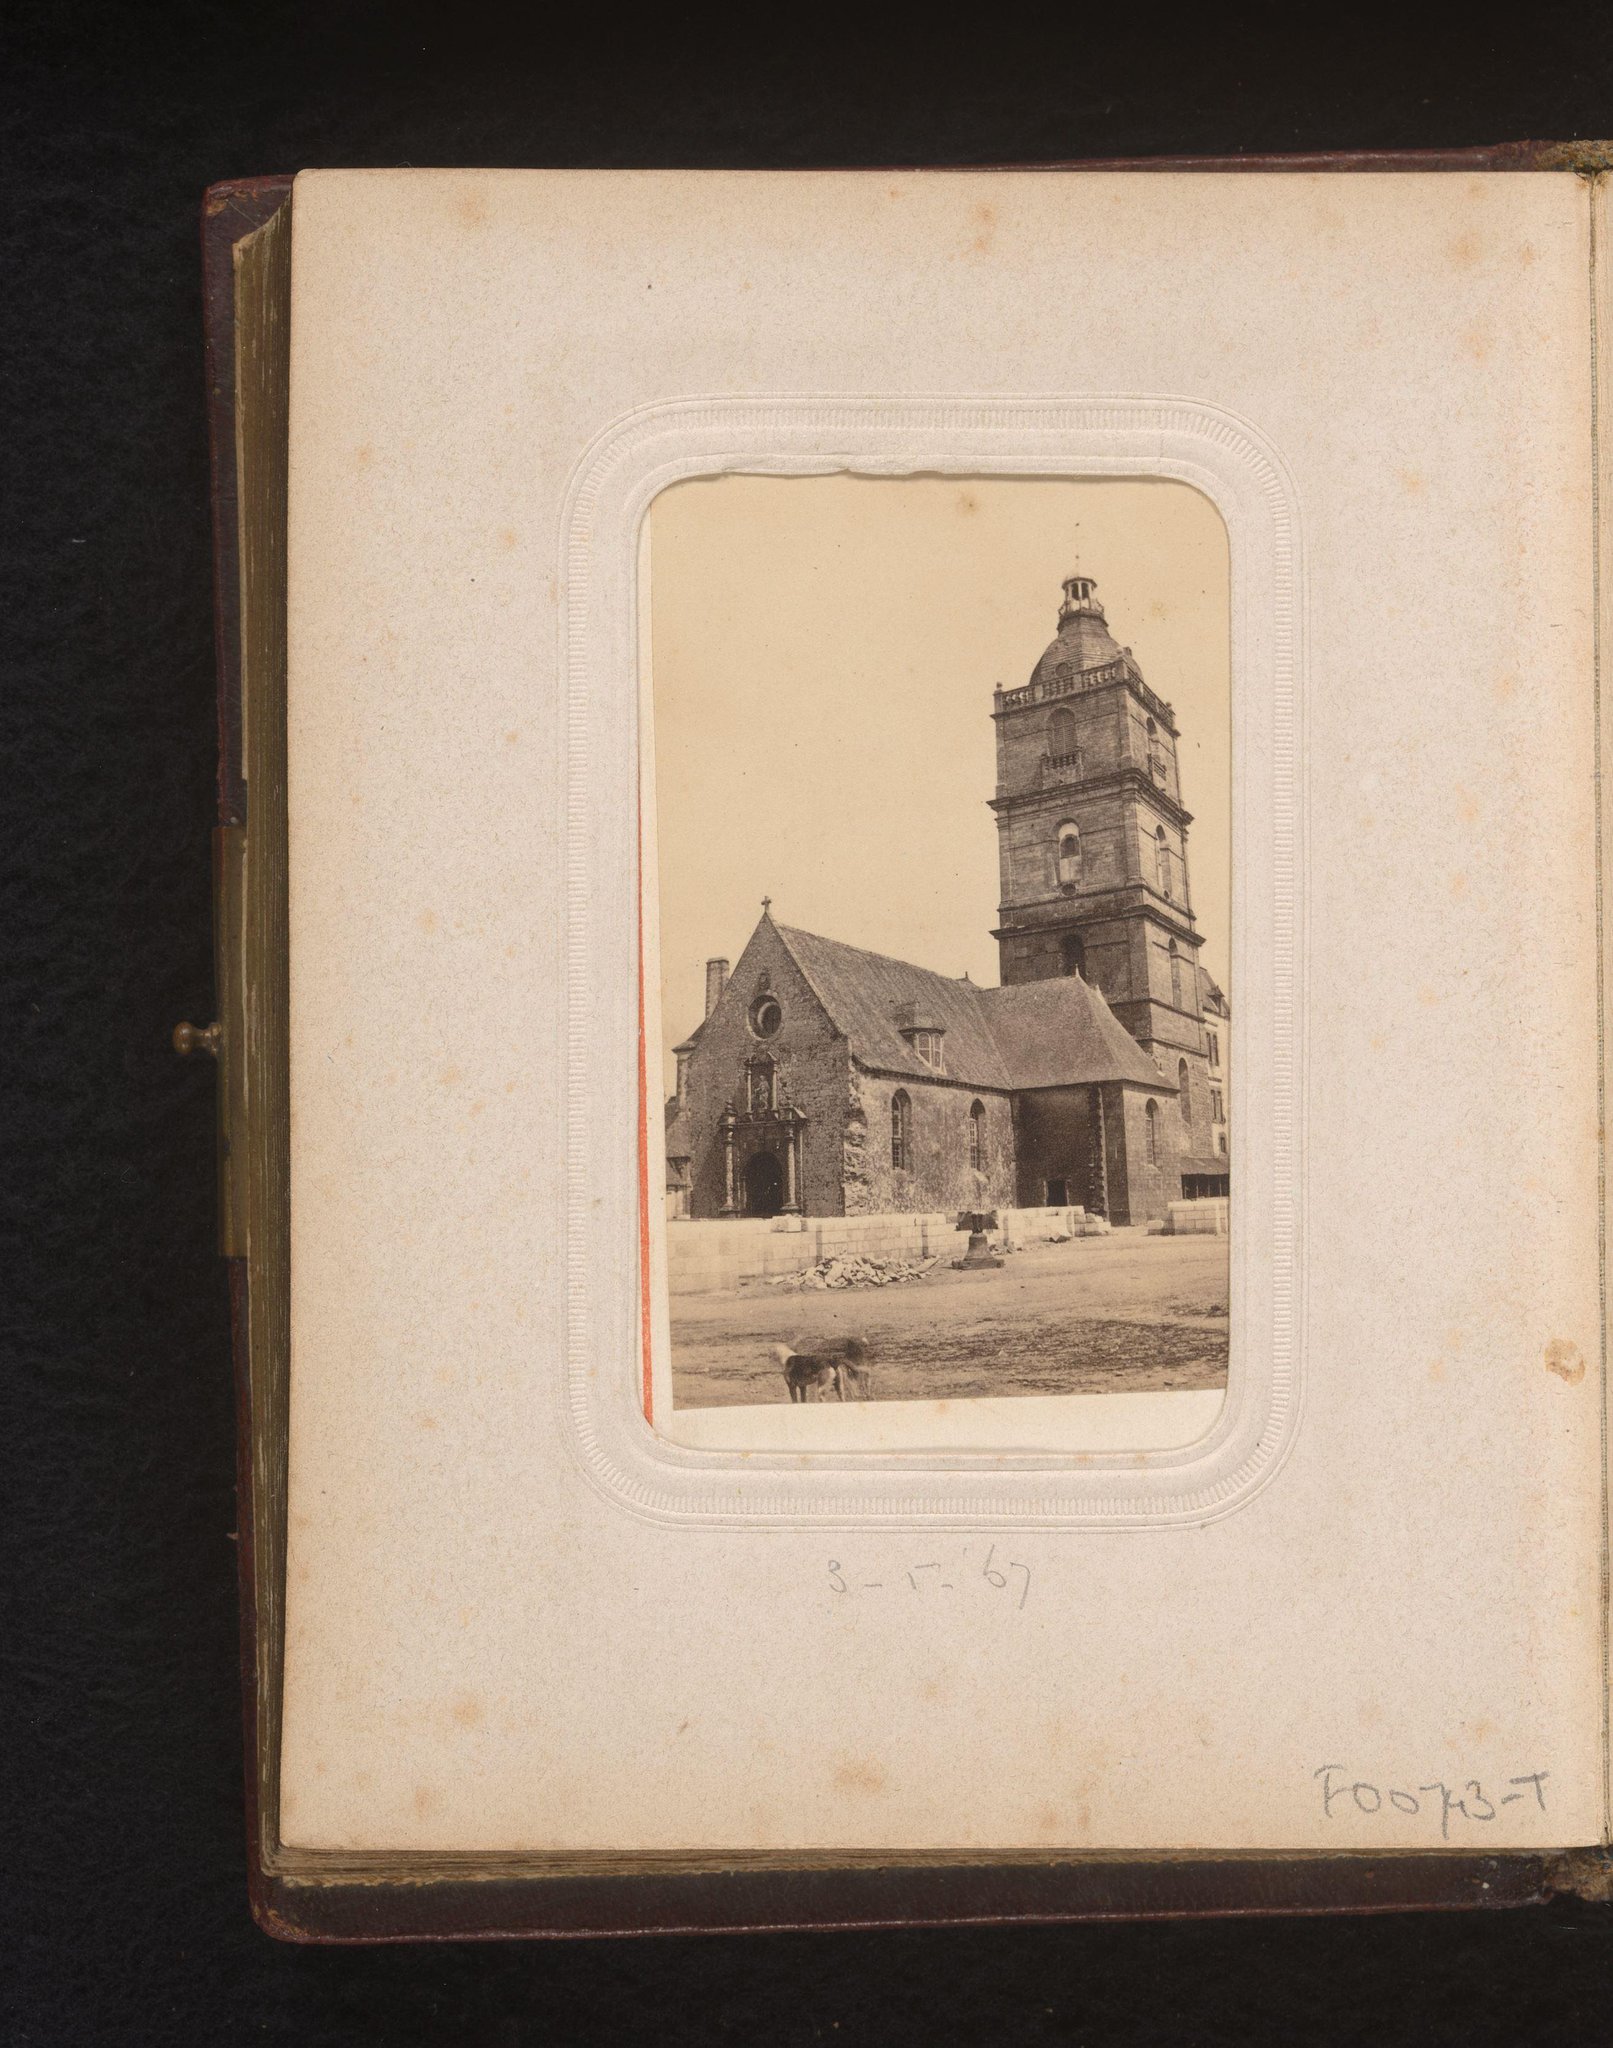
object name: album leaf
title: Gezicht op een kerk in Bretagne, Frankrijk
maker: ferdinand carlier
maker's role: fotograaf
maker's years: 1829-1892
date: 1867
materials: cardboard, photographic support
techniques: albumen print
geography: brittany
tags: church (exterior)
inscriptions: annotation: ‘[...]/ 3 mai 67’, annotation: ‘3-5-'67’, inscription: ‘F. Carlier/ PHOTOGRAPHIE PHOTOSCULPTURE/ 23, Place Napoleon, 23/ VANNES.’